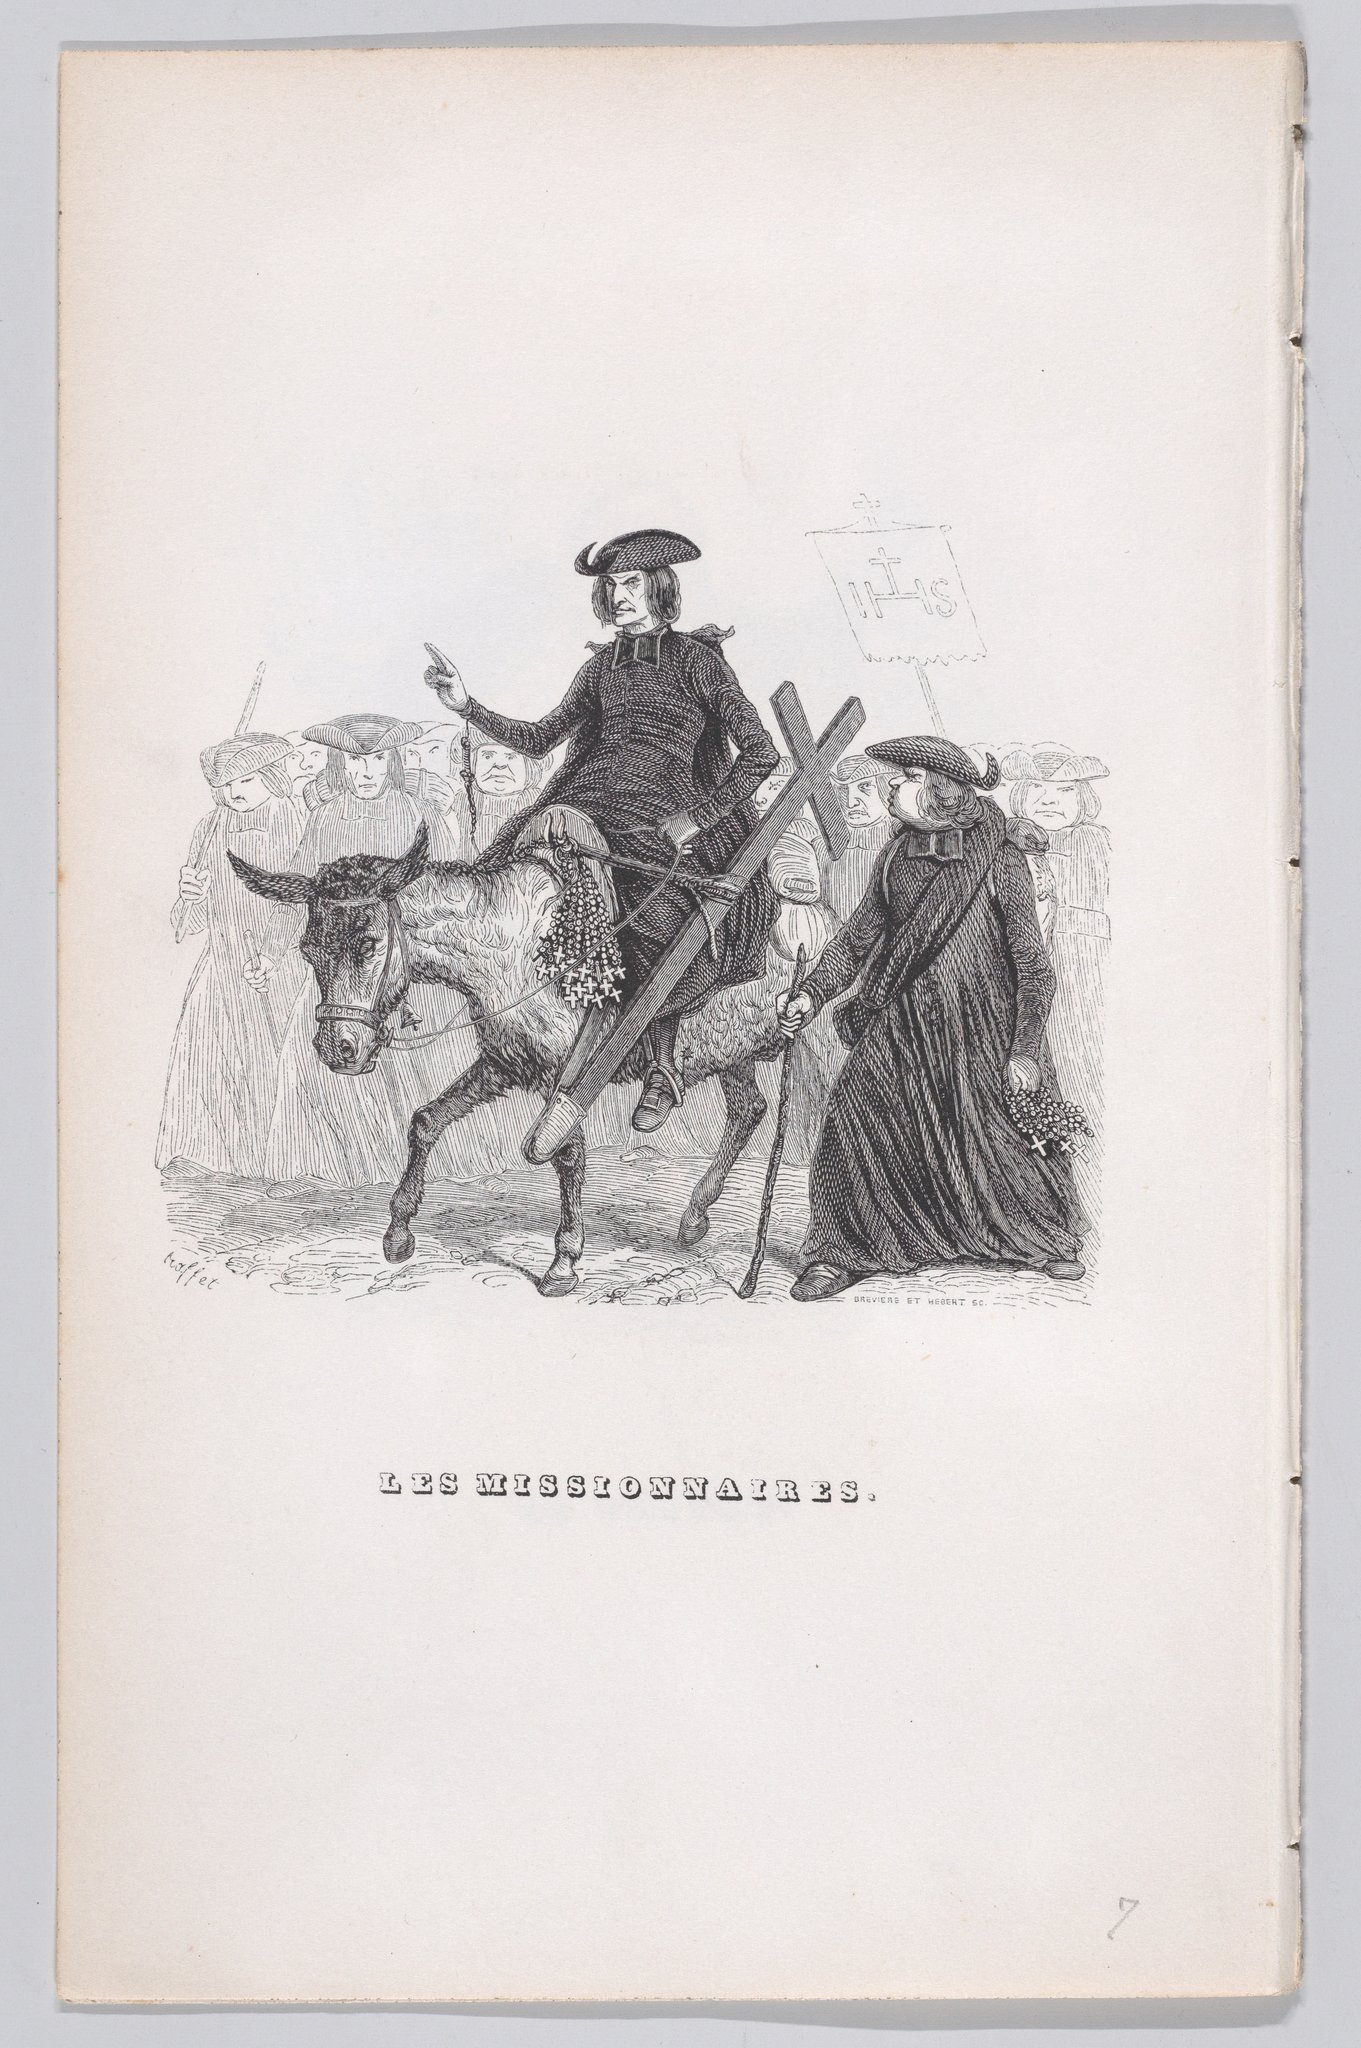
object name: print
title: The Missionaries, from "The Complete Works of Béranger"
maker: j. j. grandville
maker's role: illustrator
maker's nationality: french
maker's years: 1803-1847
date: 1836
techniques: engraving